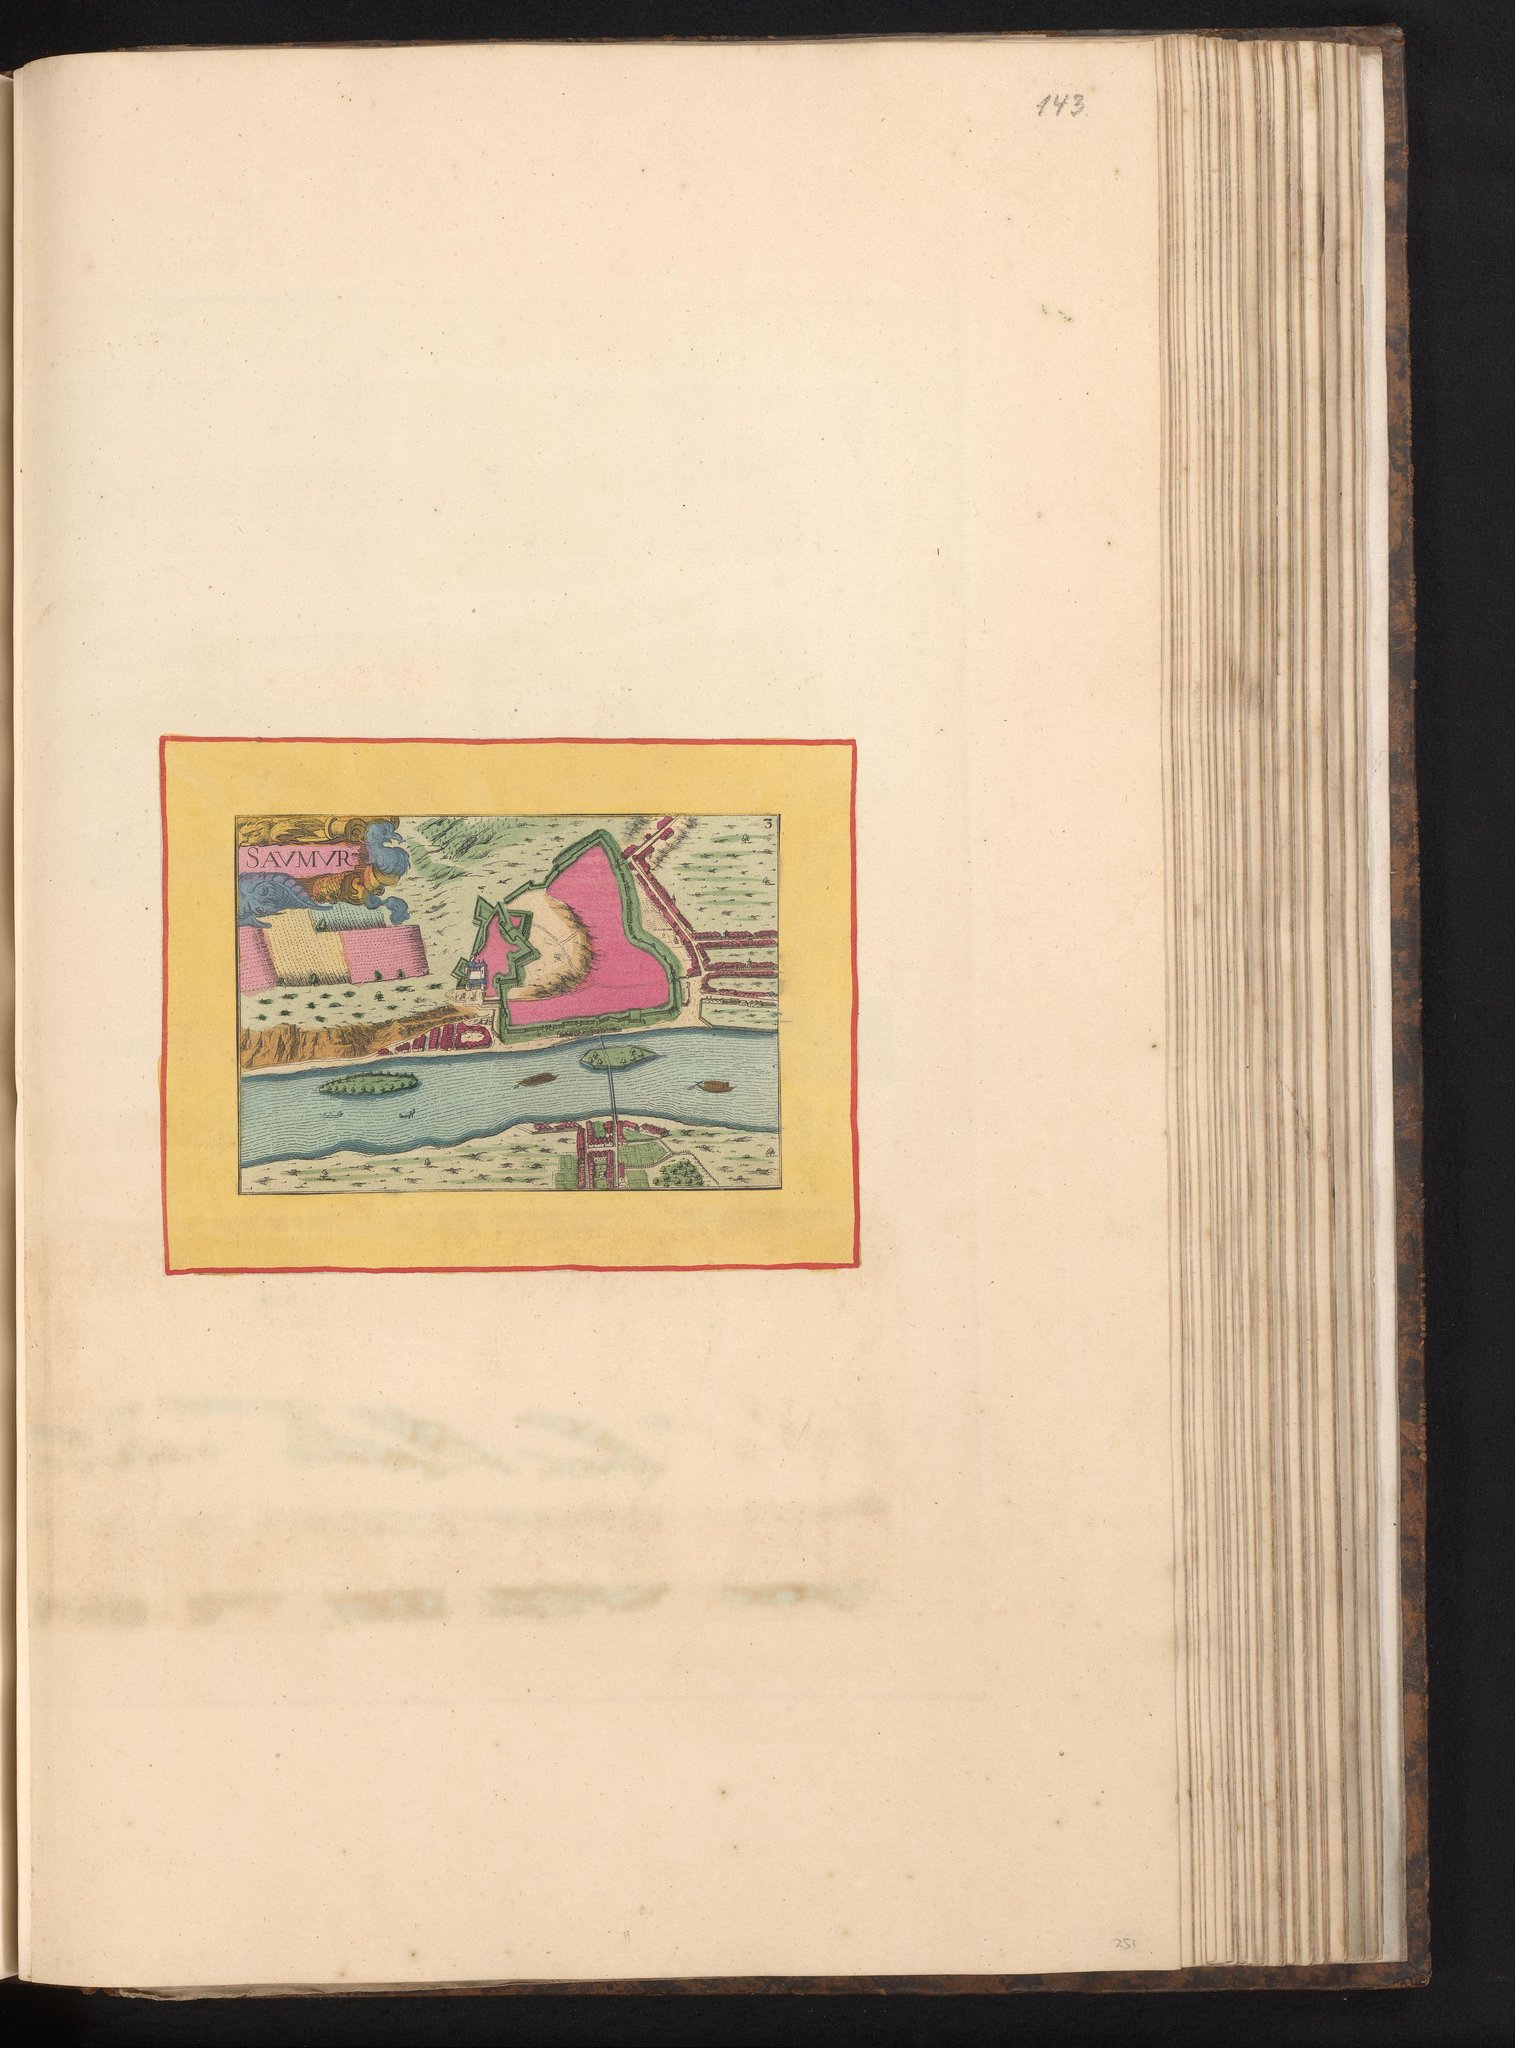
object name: area plan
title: Saumur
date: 1638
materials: paper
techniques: engraving, etching, hand coloring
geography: the hague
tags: maps of cities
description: Prent uit: Tassin, Christophe. Les plans et profils de toutes les principales villes et lieux considérables de France (...). Parijs: Michel van Lochom, 1638, prent nummer 3 in het deel 'Loire'.